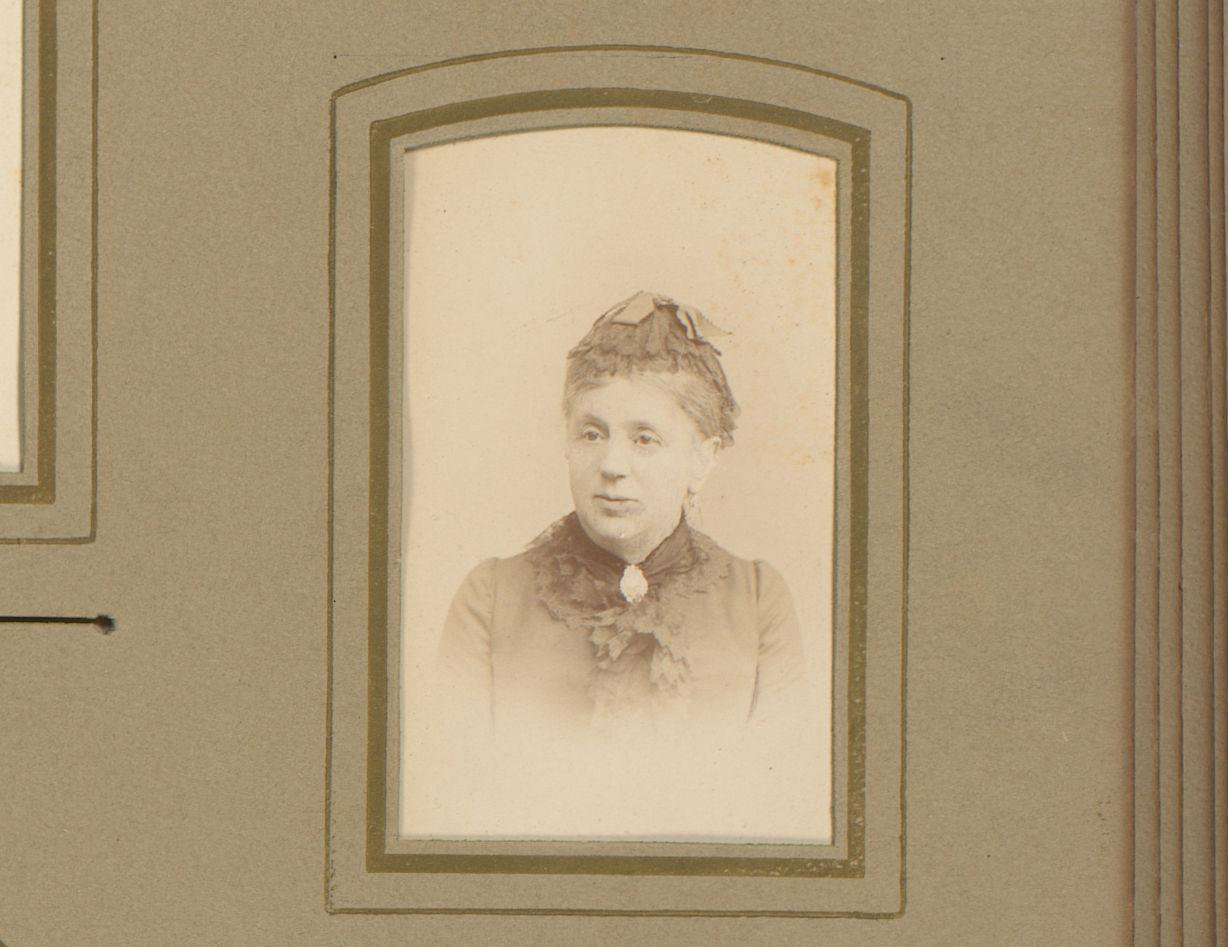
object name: album leaf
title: Portret van een vrouw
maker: emil tiedemann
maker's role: fotograaf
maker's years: 1858-1892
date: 1859-1898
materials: cardboard, photographic support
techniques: albumen print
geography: germany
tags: historical persons - bb - woman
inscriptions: inscription: ‘EMIL TIEDEMANN/ (...)/ HOF-PHOTOGRAPH/ (...)/ BREMEN/ Richtweg No 12./ (...)/ HANNOVER/ Georgstr, 13./ BRAUNSCHWEIG/ Bohlweg 66./ DESSAU/ Leopoldstr. 4./ BRAKE/ a/d. Weser.’